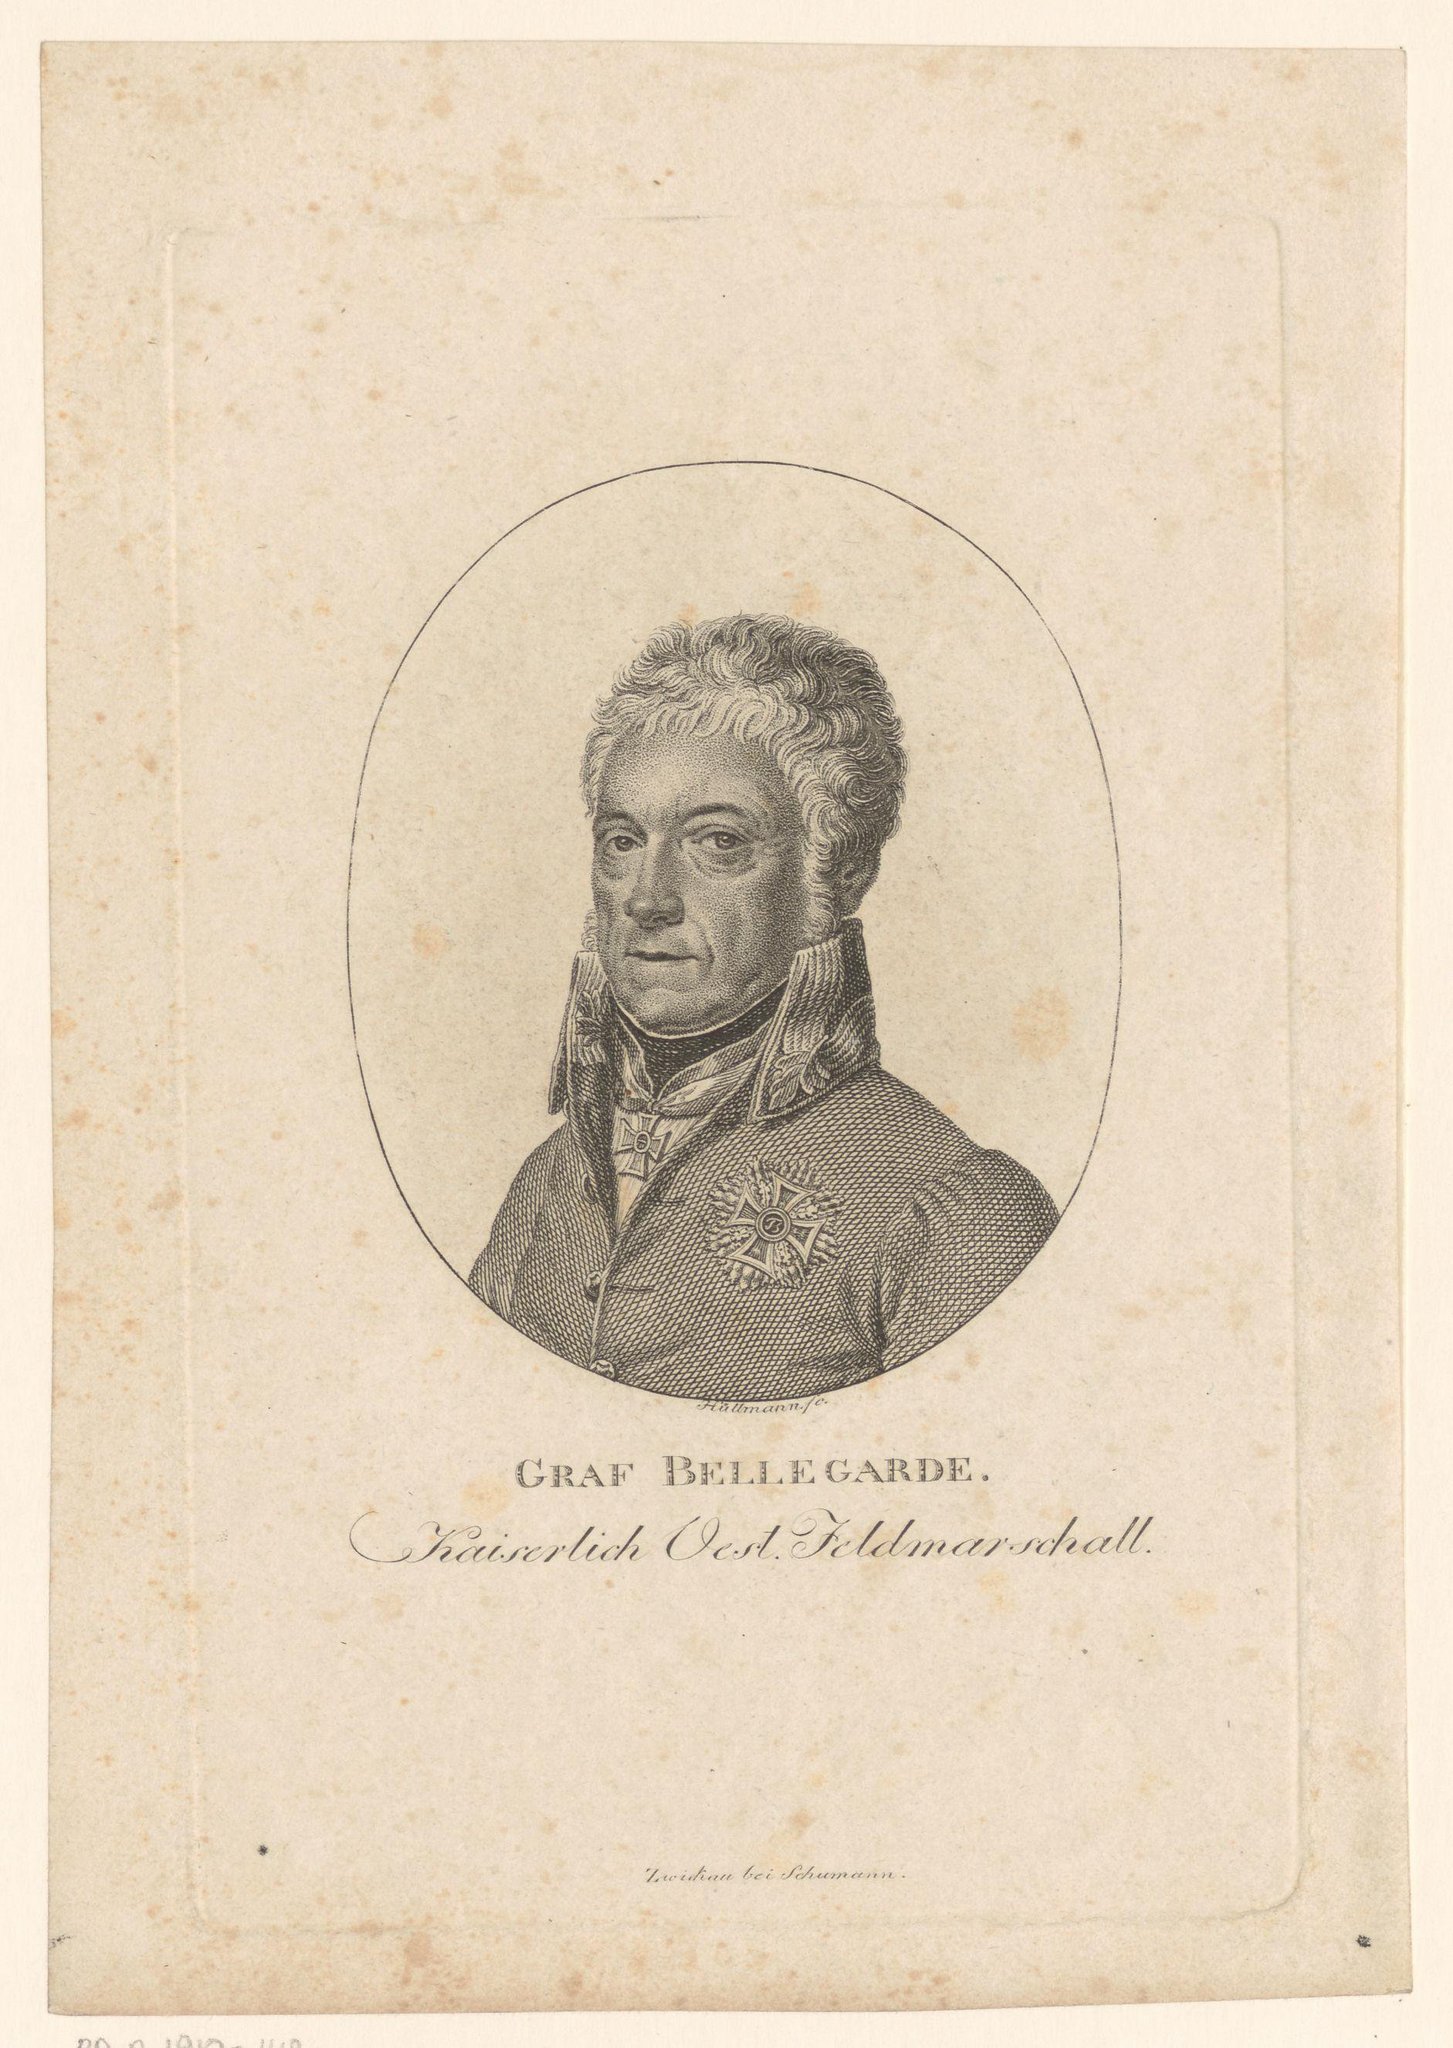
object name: print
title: Portret van Heinrich von Bellegarde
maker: gottlieb wilhelm hüllmann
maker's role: print maker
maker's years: 1765-1828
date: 1775-1828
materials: paper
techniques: engraving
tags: vienna, earl, knighthood order (with name) - insignia of a knighthood order, e.g.: badge, chain (with name of order), historical persons, officer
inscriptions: collector's mark: Lugt 2228